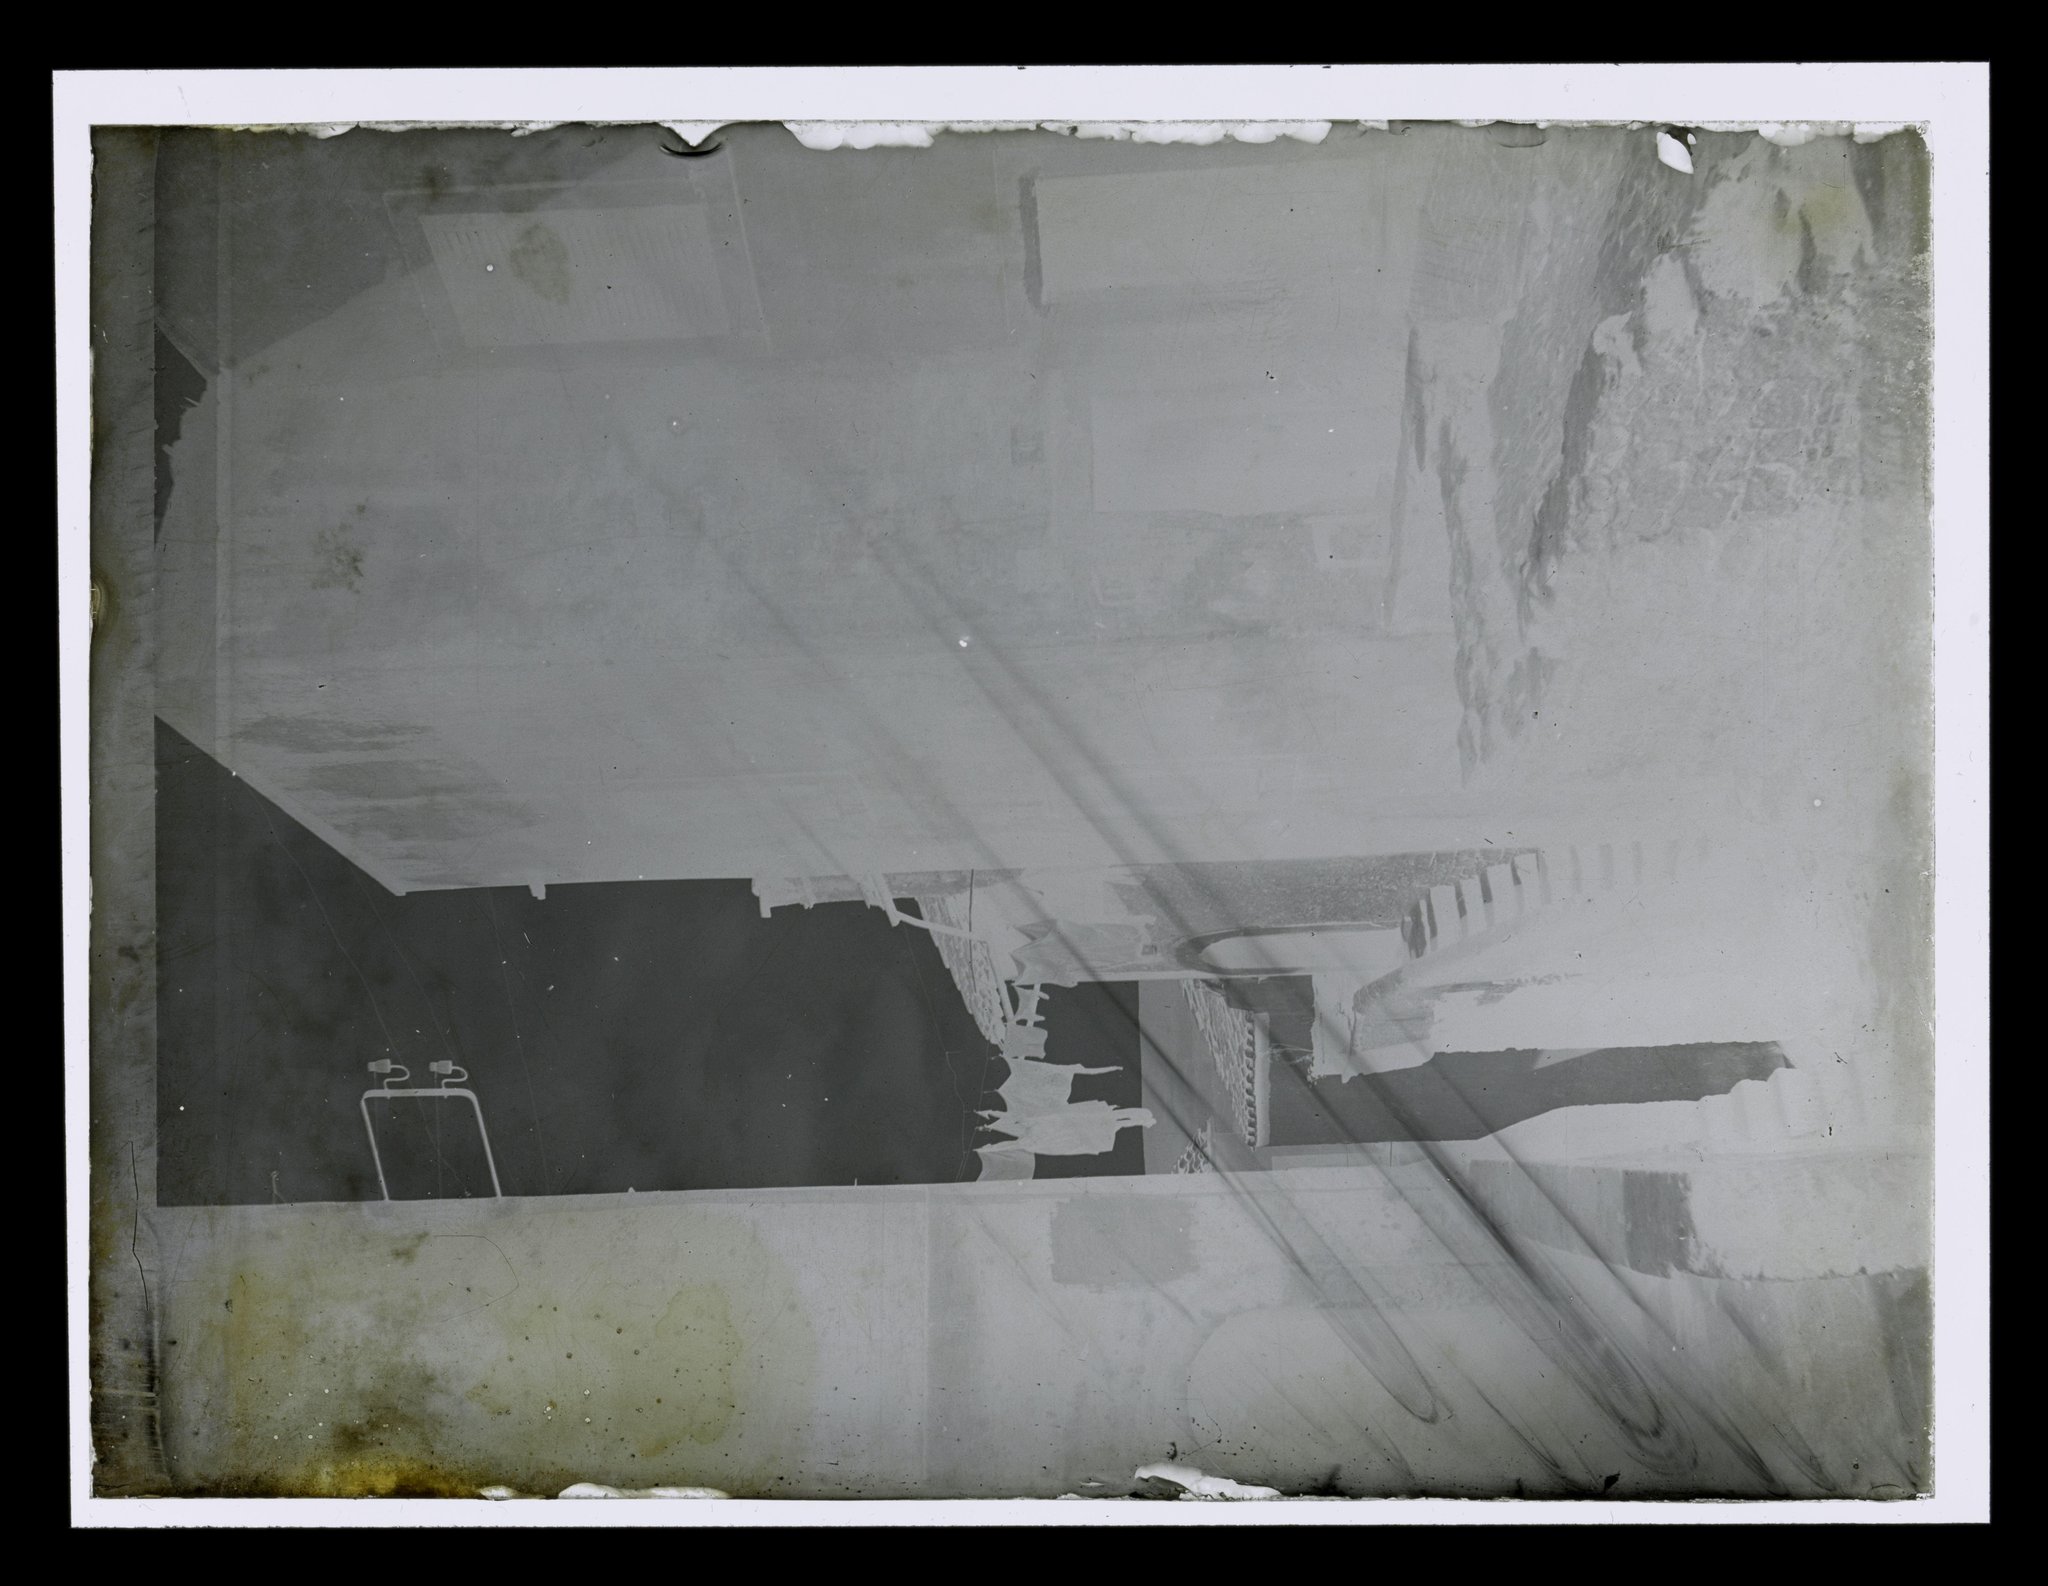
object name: glasnegatief, glasplaatnegatief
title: Gezicht op een steeg met hangend wasgoed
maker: laurens lodewijk kleijn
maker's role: draughtsman, painter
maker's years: 1826-1909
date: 1865-1900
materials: glass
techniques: collodion process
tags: lane, alley, hanging the wash to dry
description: Onderdeel van groep glasnegatieven uit de nalatenschap van de schilder Laurens Lodewijk Kleijn, stillevens, portretten, zelfportretten en kunstreproducties.